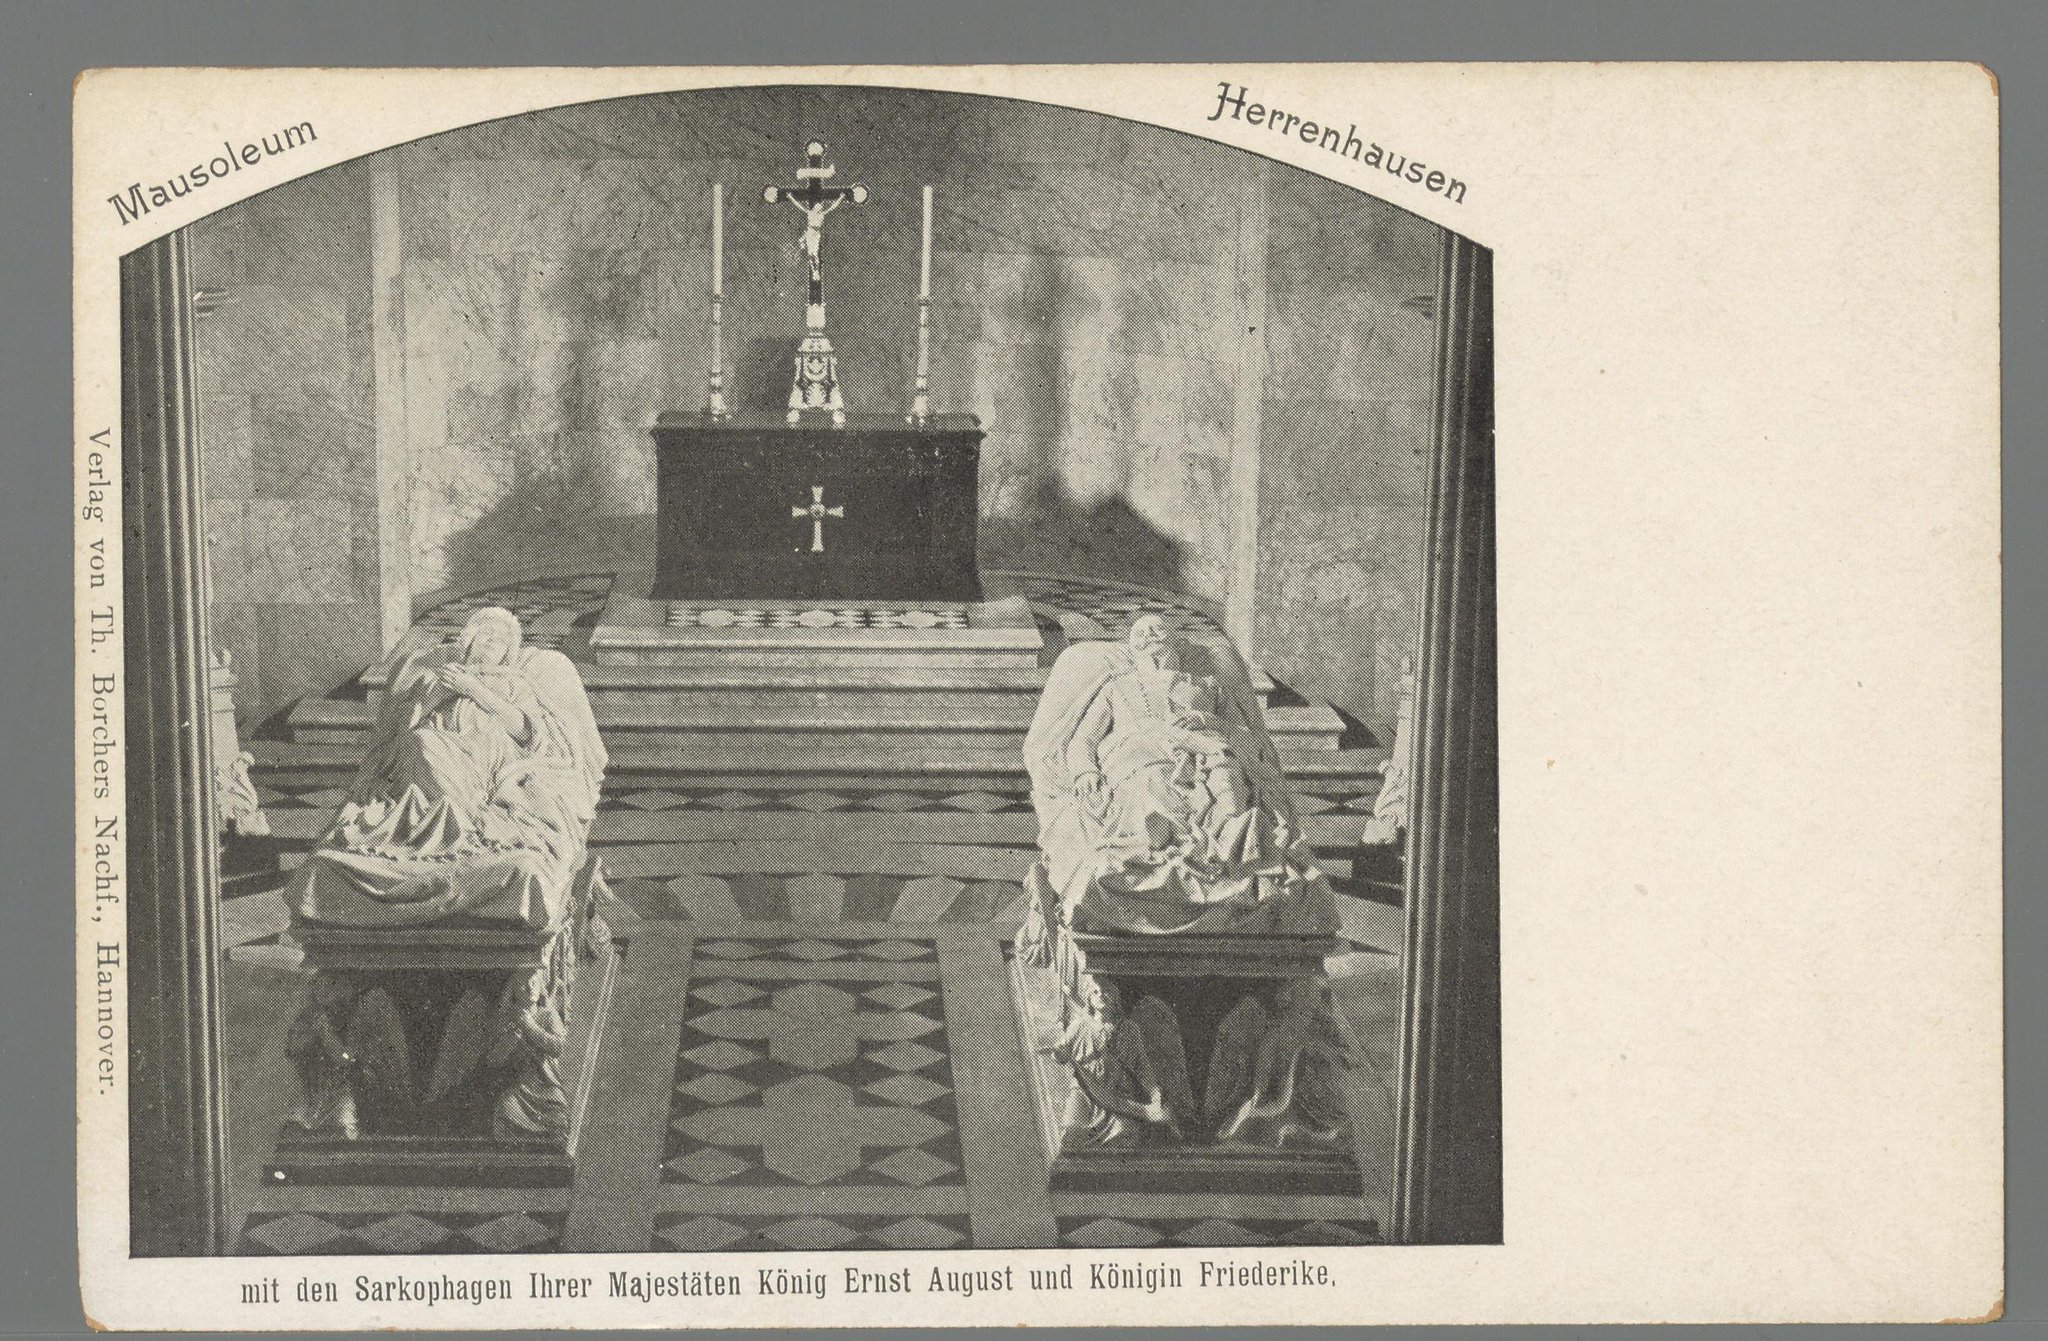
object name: photomechanical print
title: Mausoleum Herrenhausen mit den Sarkophagen Ihrer Majestäten König Ernst August und Königin Friederike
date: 1885-1905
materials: cardboard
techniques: autotype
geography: hannover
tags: mausoleum, sarcophagus